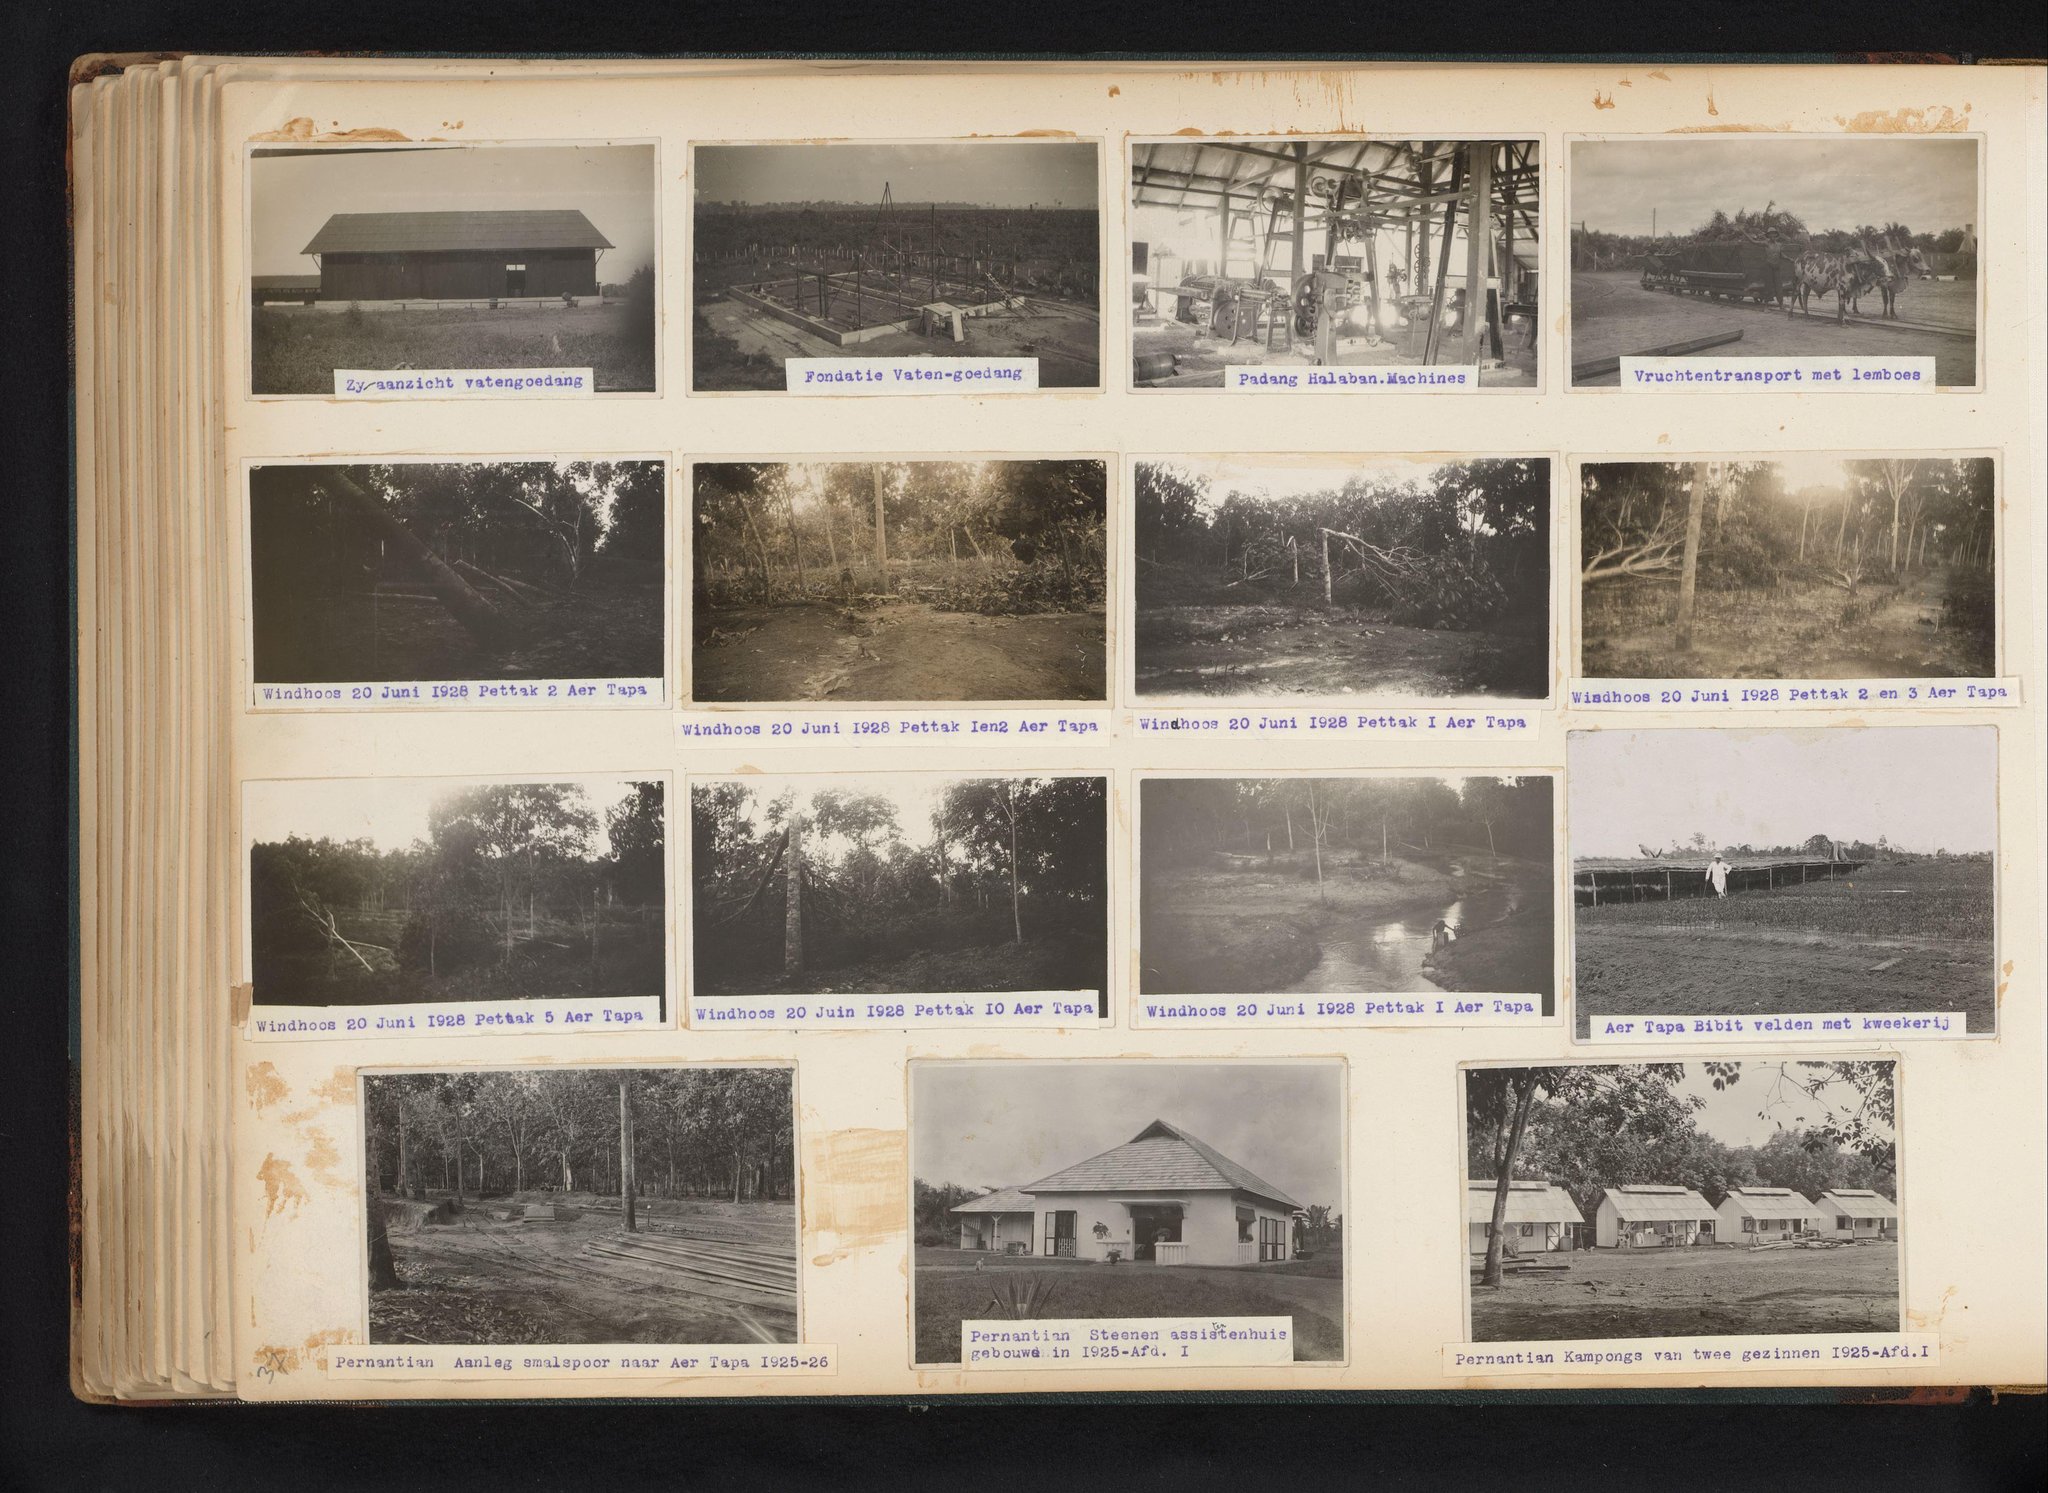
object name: photograph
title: Bedrijfsgebouwen en stormschade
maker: Anonymous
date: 1928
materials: cardboard, photographic support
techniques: gelatin silver print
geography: east sumatra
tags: plantation, factory-building, whirlwind, cyclone, hurricane, typhoon, tornado on land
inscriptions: inscription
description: Blad met vijftien foto's van de bouw van een loods voor de opslag van vaten, van schade aan bomen door een windhoos op 20 juni 1928 en van gebouwen op Pernantian. Onder de foto's etiketten met onderschriften. Onderdeel van het fotoalbum over de plantages Brussel en Pernantian van de Sumatra Caoutchouc Maatschappij op de Oostkust van Sumatra in de jaren 1910-1935.